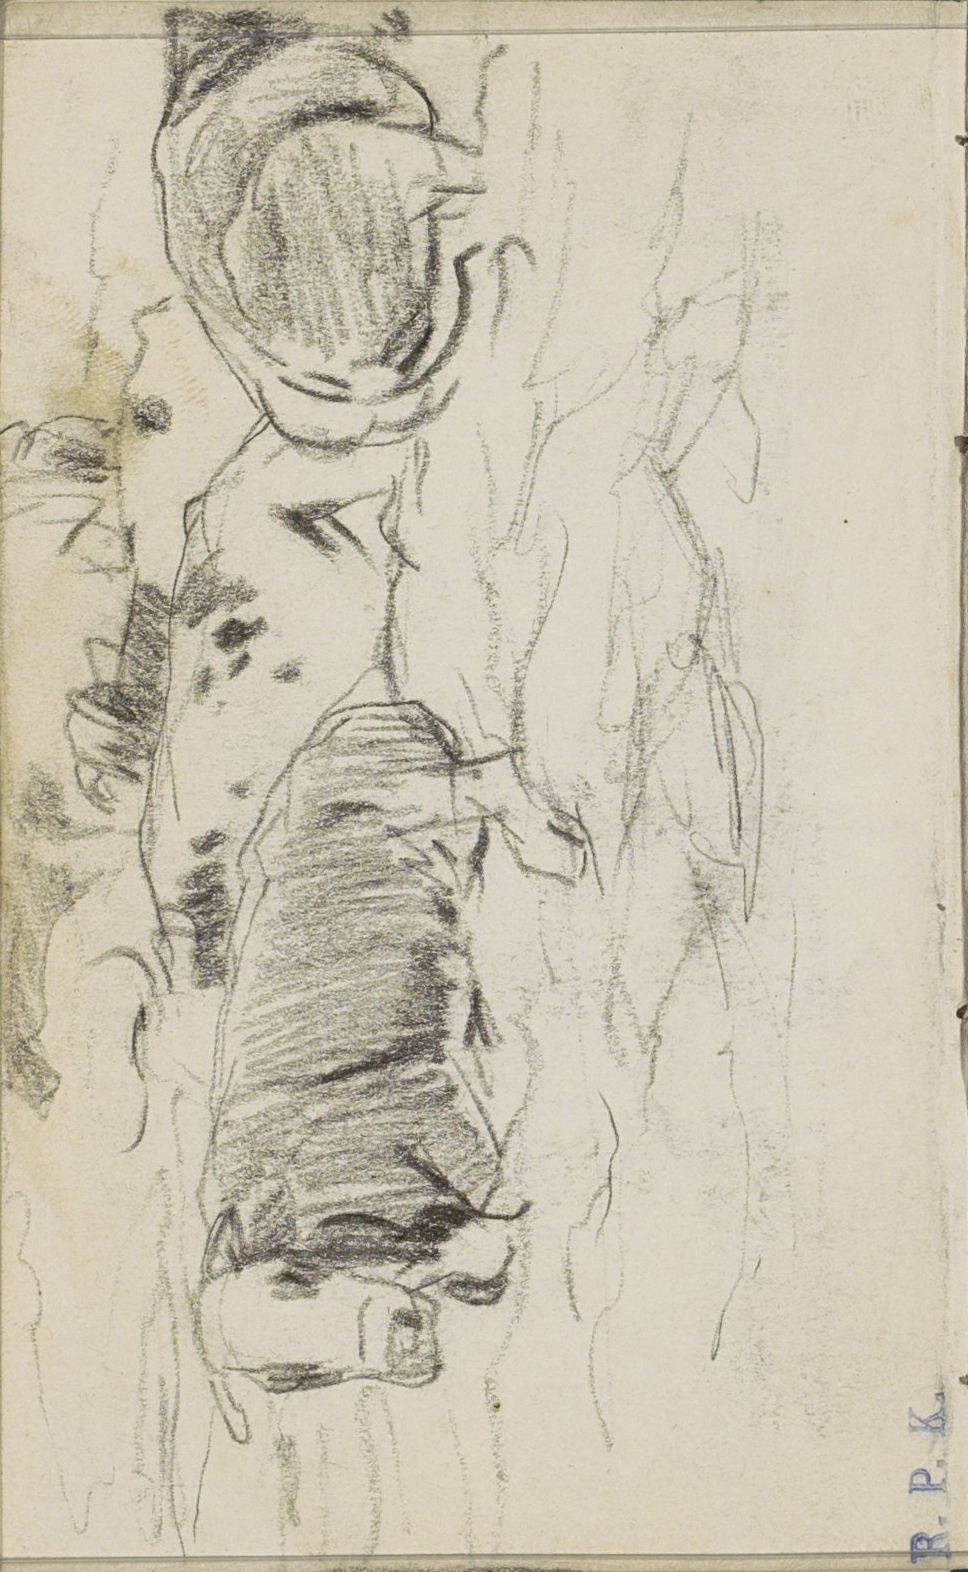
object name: sketchbook leaf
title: Liggende koeien in een weiland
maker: anton mauve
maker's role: draughtsman, painter, print maker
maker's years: 1838-1888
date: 1848-1888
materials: chalk, paper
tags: cow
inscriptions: collector's mark: Lugt L.2233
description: Blad 3 verso uit een schetsboek met 53 bladen.